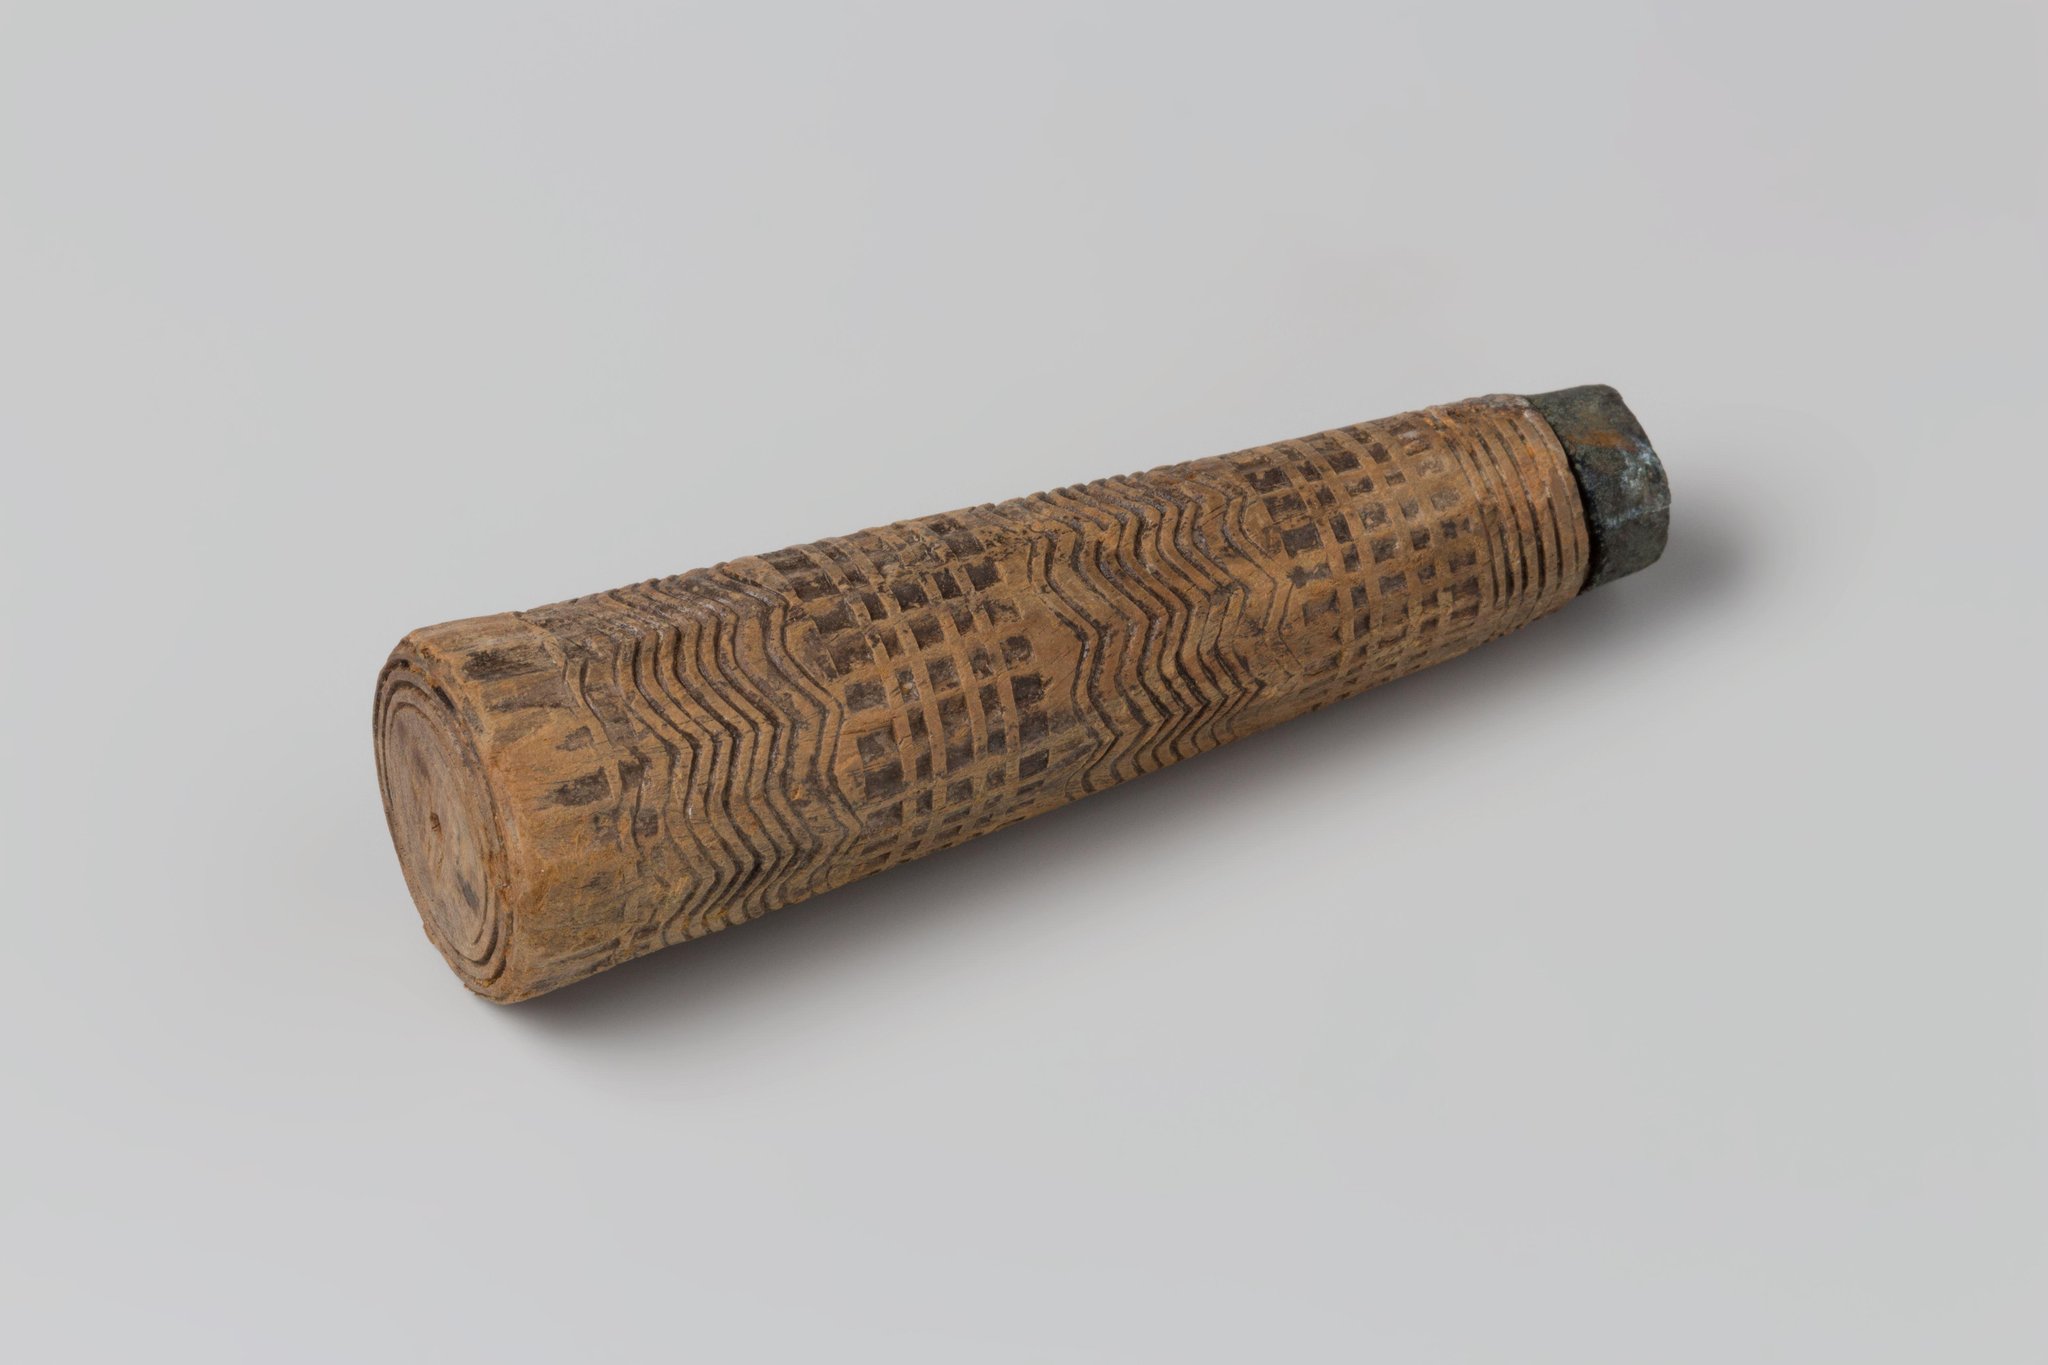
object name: knife handle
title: Messenheft uit het wrak van de Oost-Indiëvaarder Hollandia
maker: Anonymous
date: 1700-1743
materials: copper, wood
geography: netherlands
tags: verenigde oostindische compagnie, hollandia (schip), annet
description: Knife, handle, cylindrical: tapering; id. NG 1979-403H, ferrules, id. NG 1980-27H426.